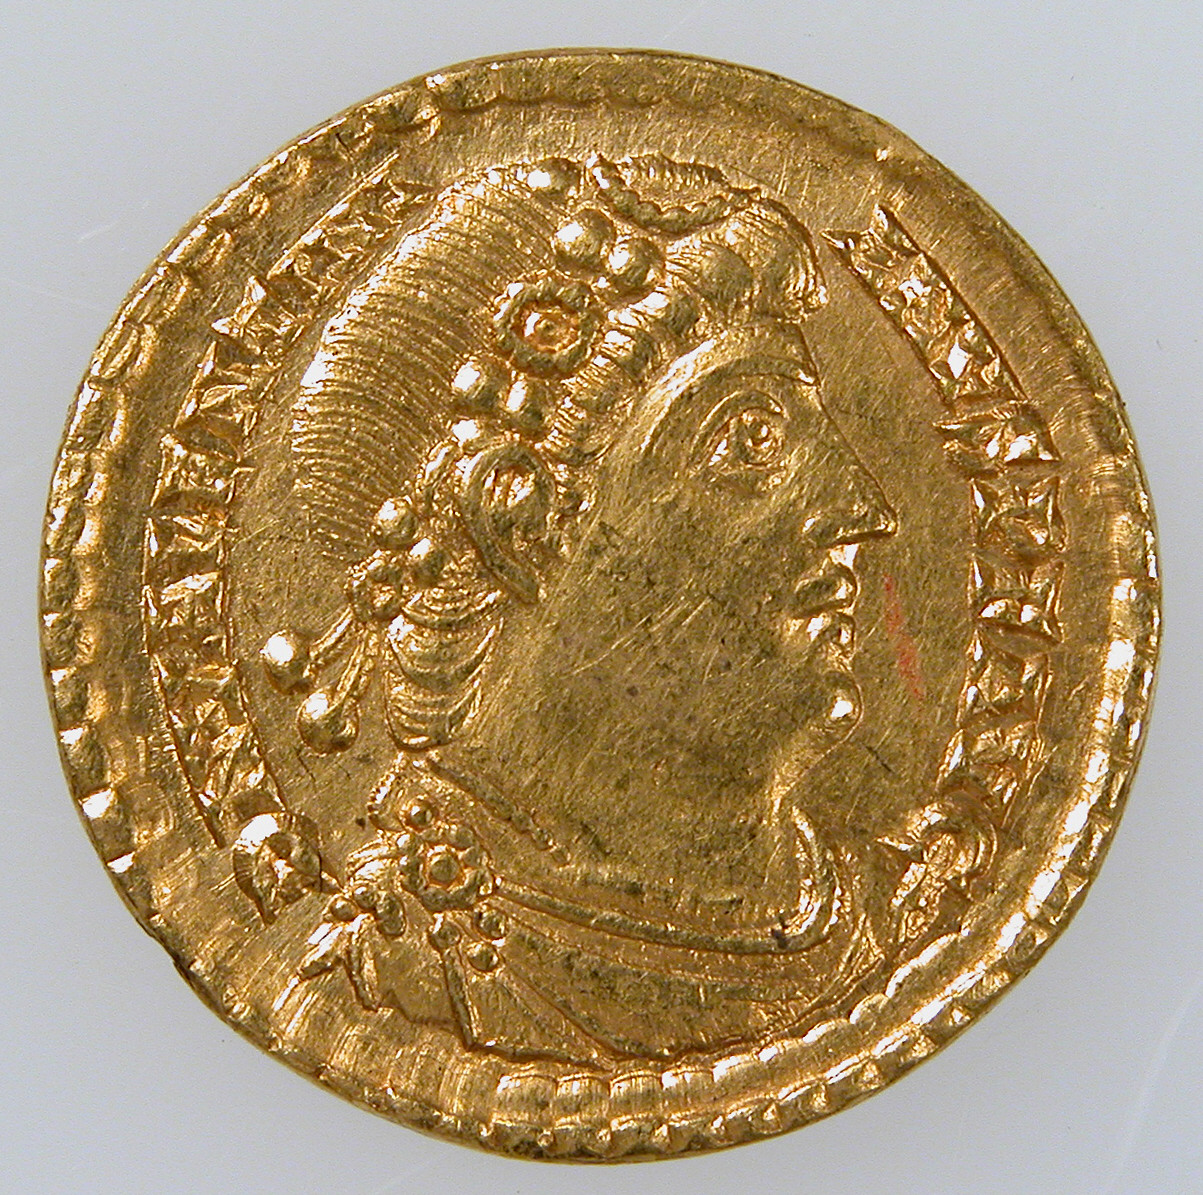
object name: solidus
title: Gold Solidus of Emperor Valentinian I (r. 364–75)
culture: byzantine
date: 364-375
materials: gold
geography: germany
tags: profiles